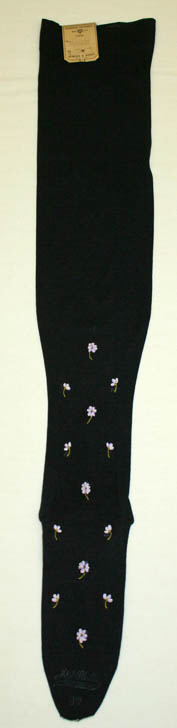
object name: stocking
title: Stockings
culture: american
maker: j. & j. slater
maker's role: designer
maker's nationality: american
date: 1900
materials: silk